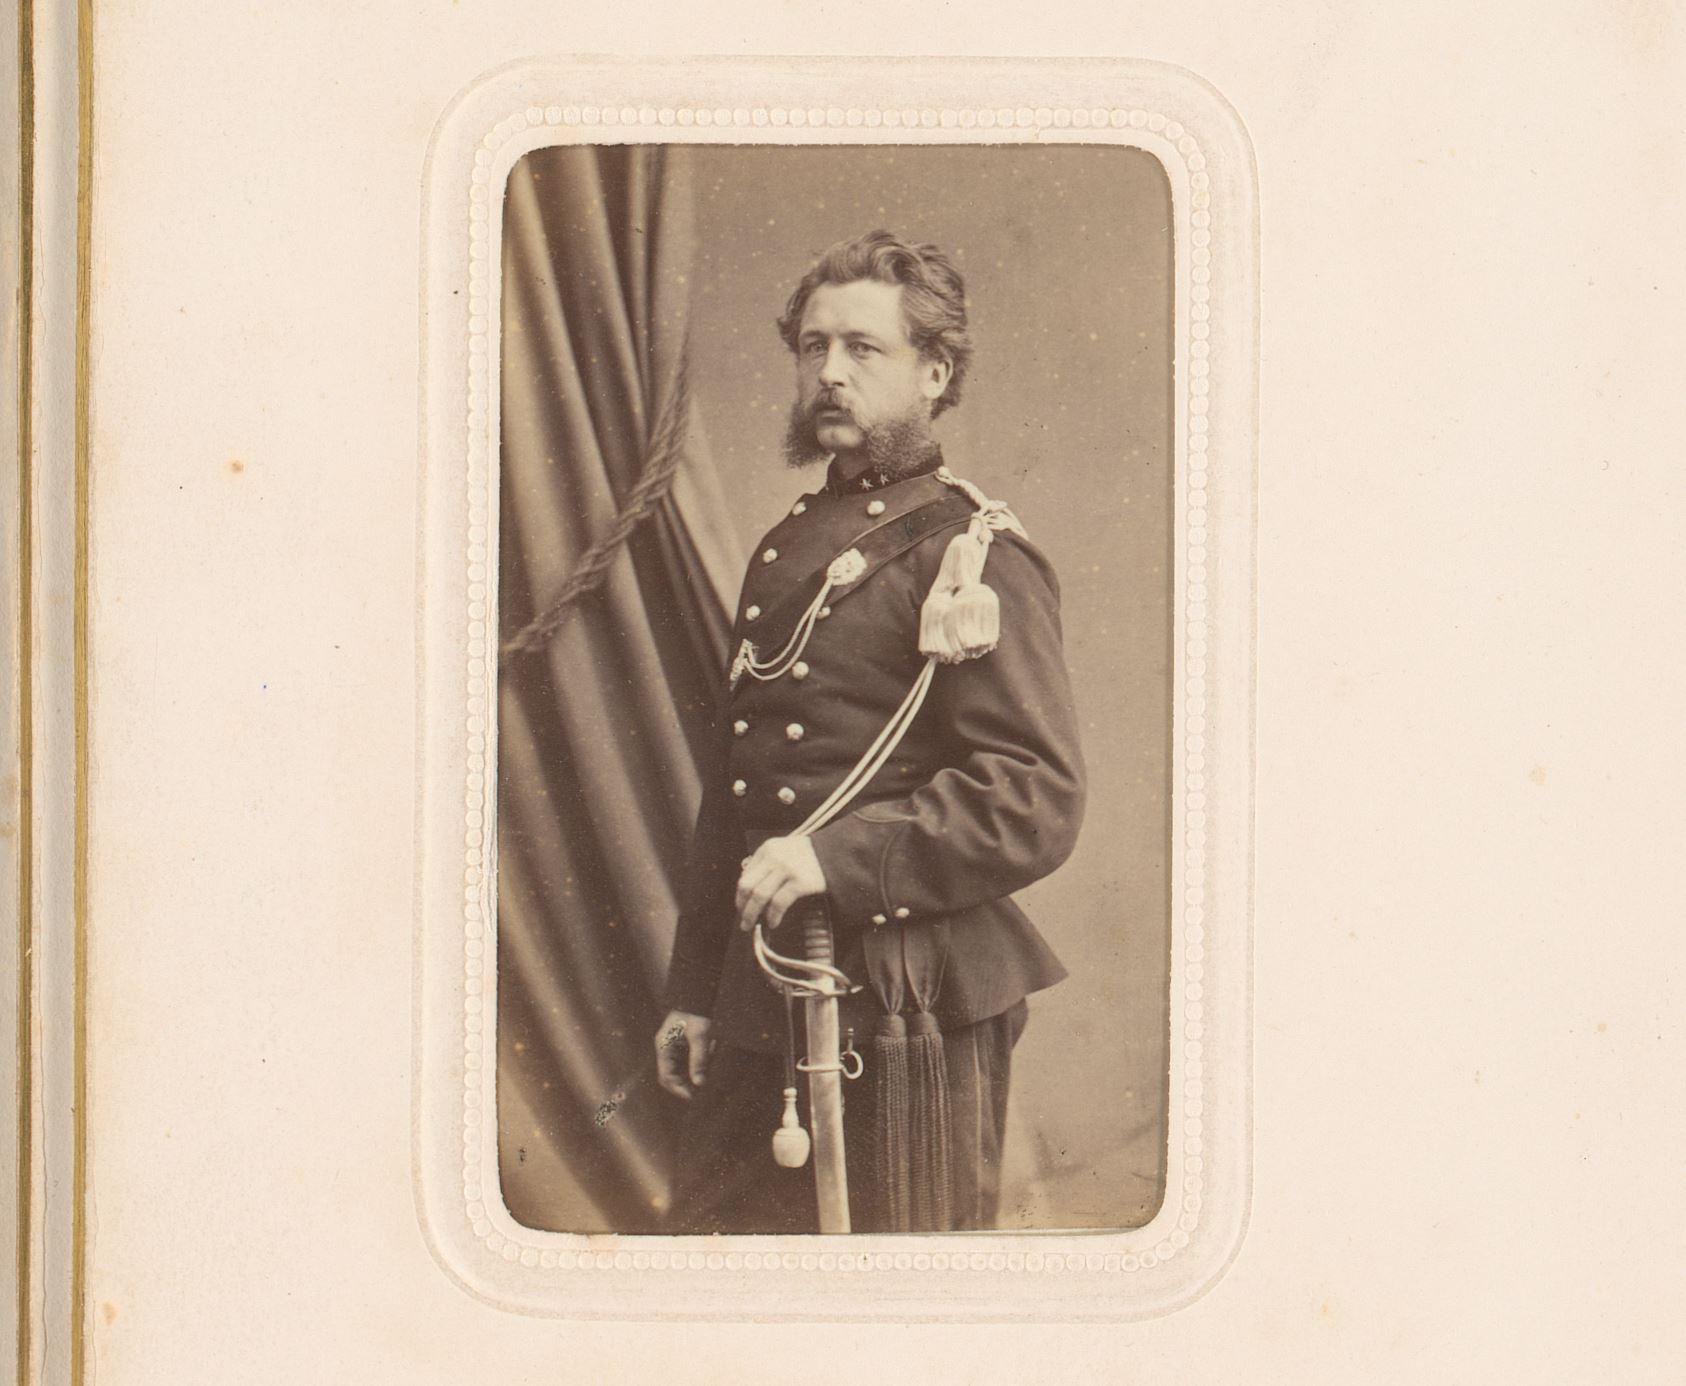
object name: carte de visite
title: Portret van een staande man in militair uniform met sabel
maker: albert greiner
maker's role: fotograaf, fotostudio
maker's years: 1833-1890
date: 1861-1874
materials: cardboard, paper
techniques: albumen print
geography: amsterdam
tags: hacking and thrusting weapons (with name), historical persons, (military) uniforms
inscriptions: inscription: ‘Nieuwendijk L87, Amsterdam’